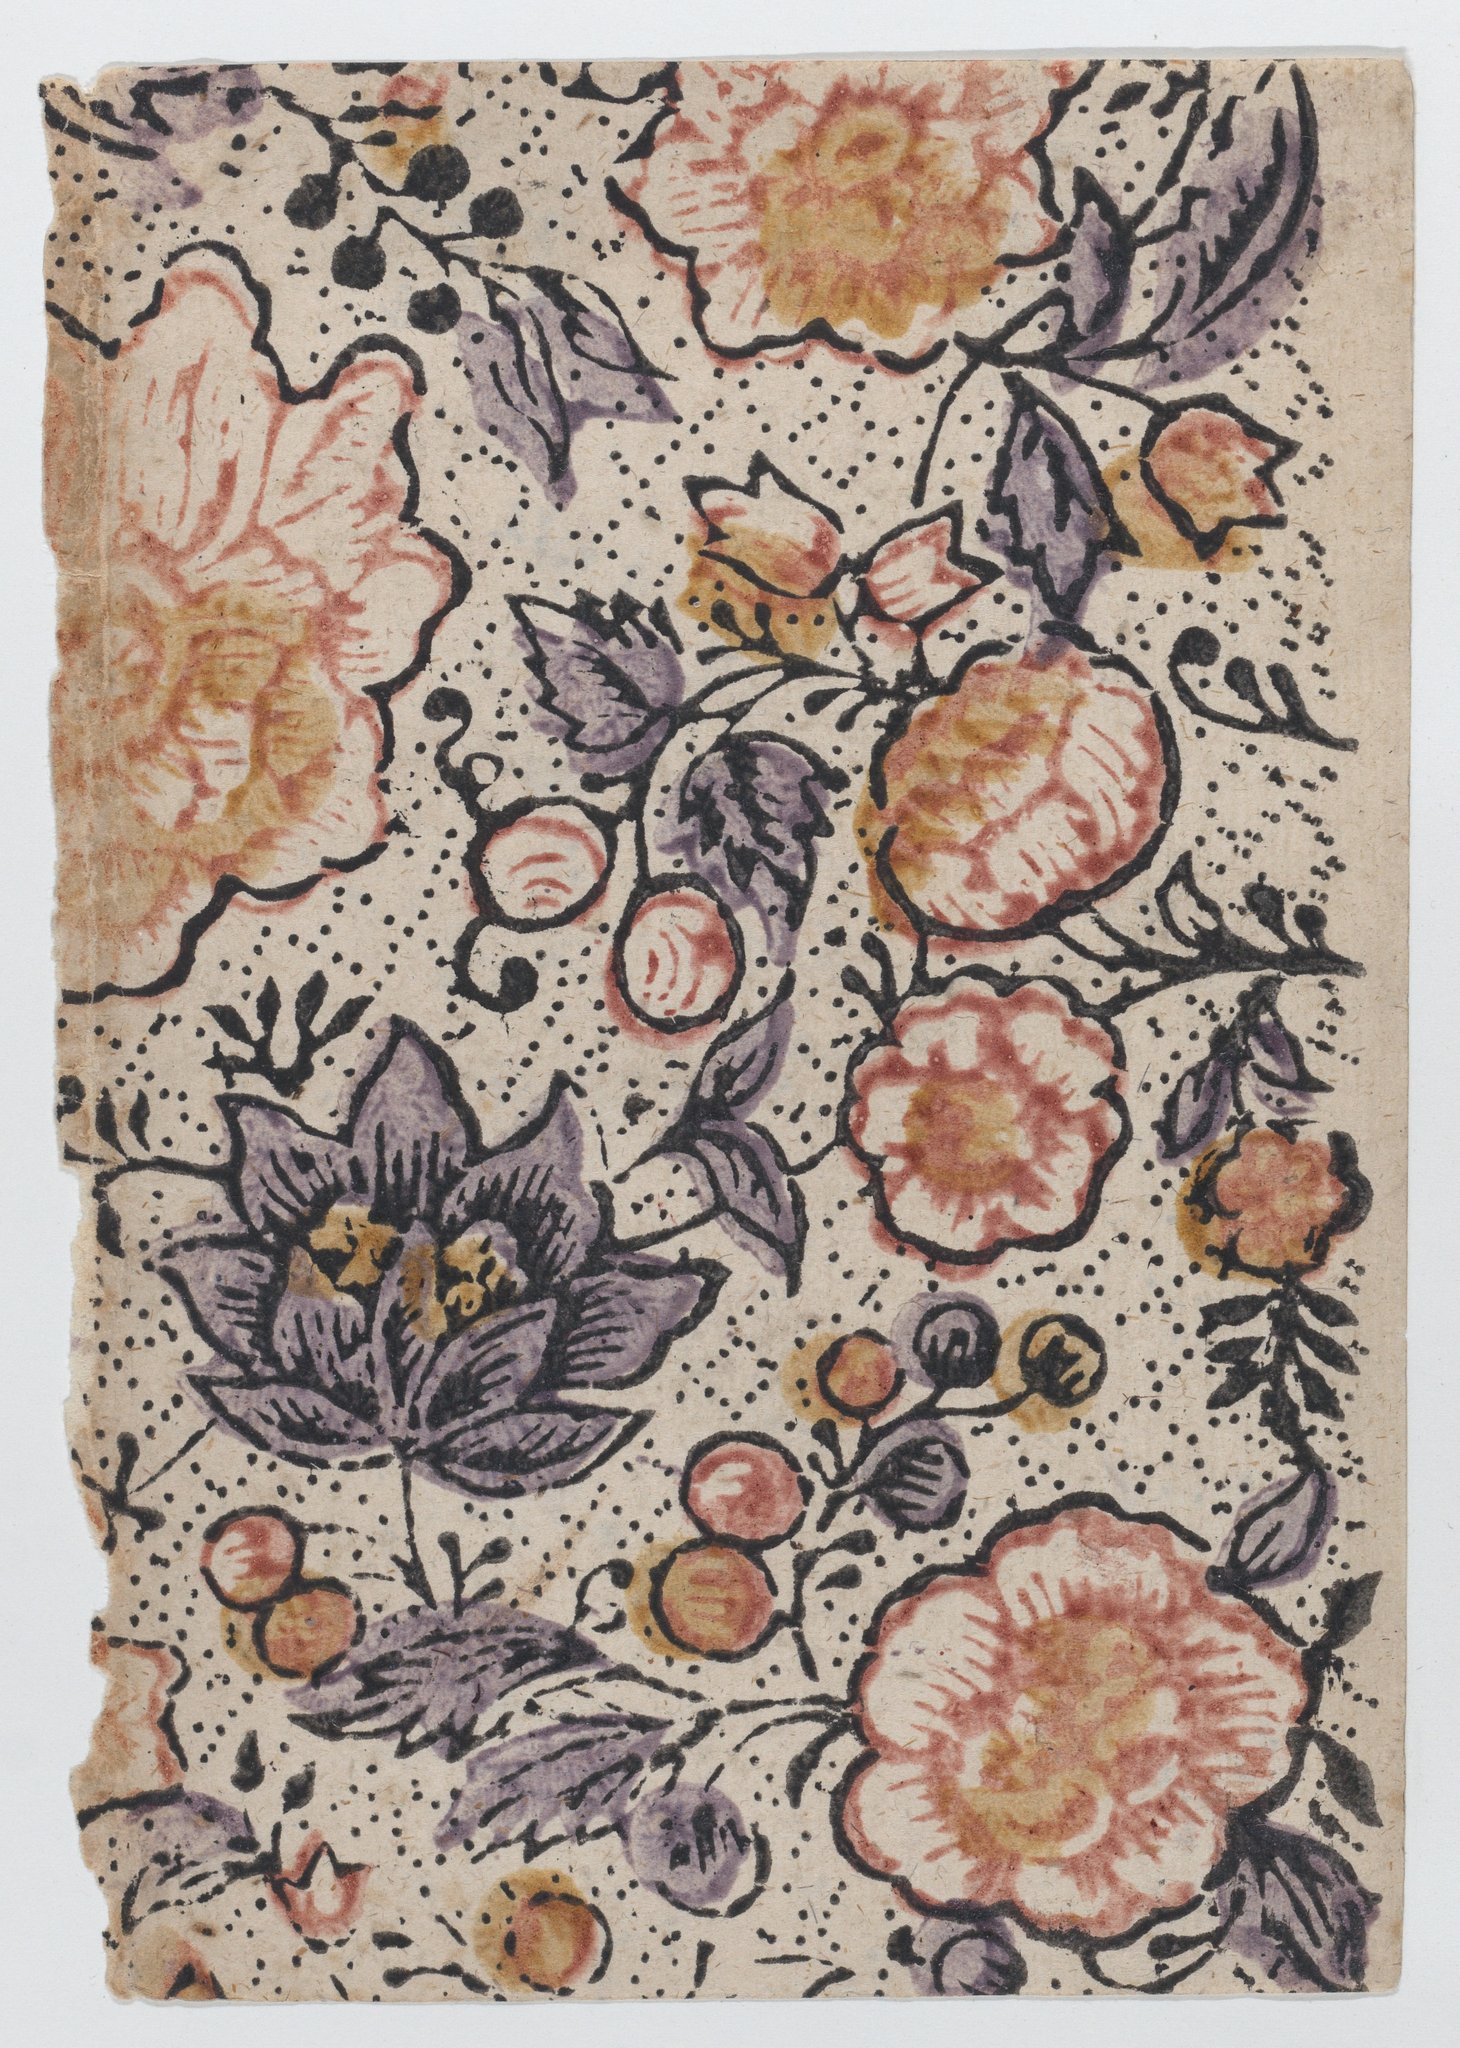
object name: print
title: Sheet with overall floral and dot pattern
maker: Anonymous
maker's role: artist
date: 1801-1900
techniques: relief print